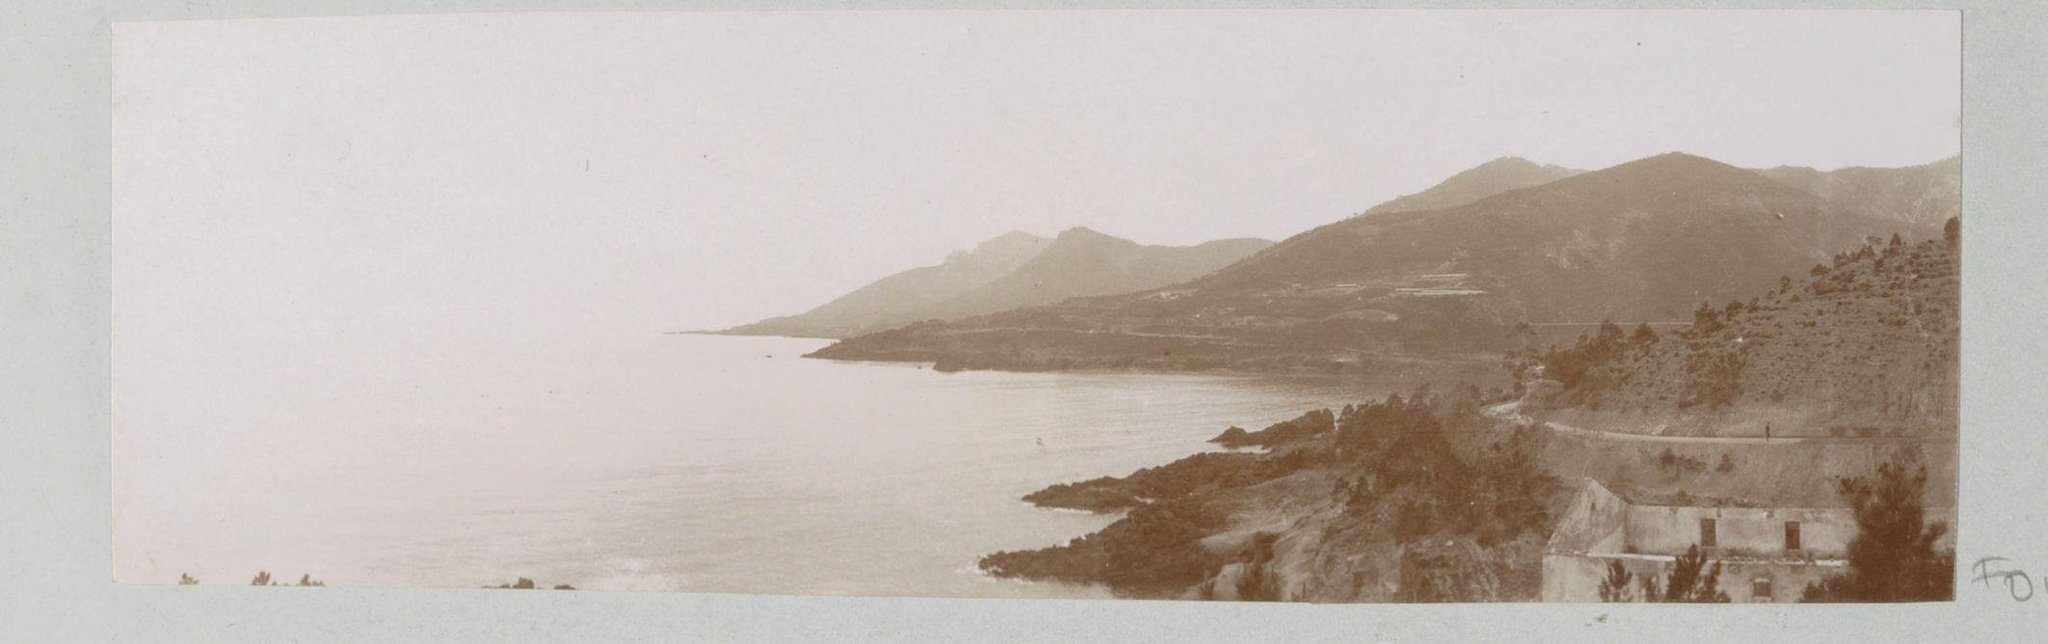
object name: panoramic photograph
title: Gezicht op de kust bij (vermoedelijk) Carqueiranne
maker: delizy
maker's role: manufacturer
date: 1903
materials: paper, photographic support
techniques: gelatin silver print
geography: carqueiranne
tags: coast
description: Onderdeel van Fotoalbum van een Franse amateurfotograaf met opnames van uitstapjes in Frankrijk, Spanje, België, Luxemburg en Nederland, de eerste automobielen en autoraces.